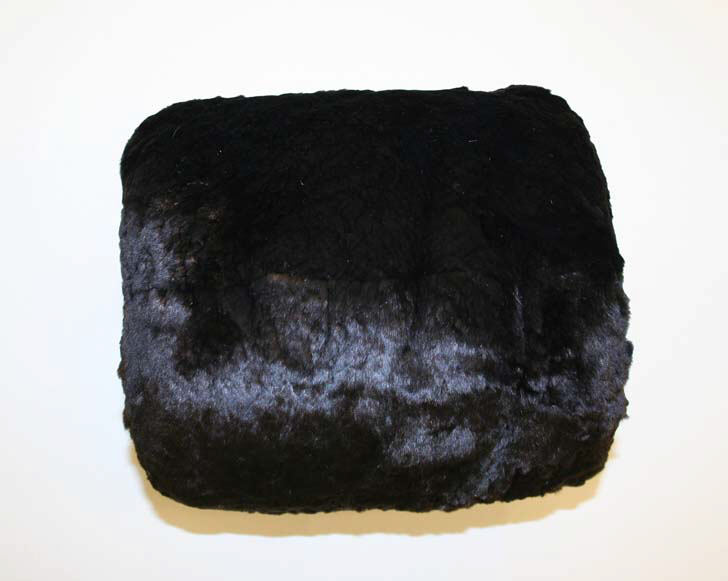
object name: muff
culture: american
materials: fur